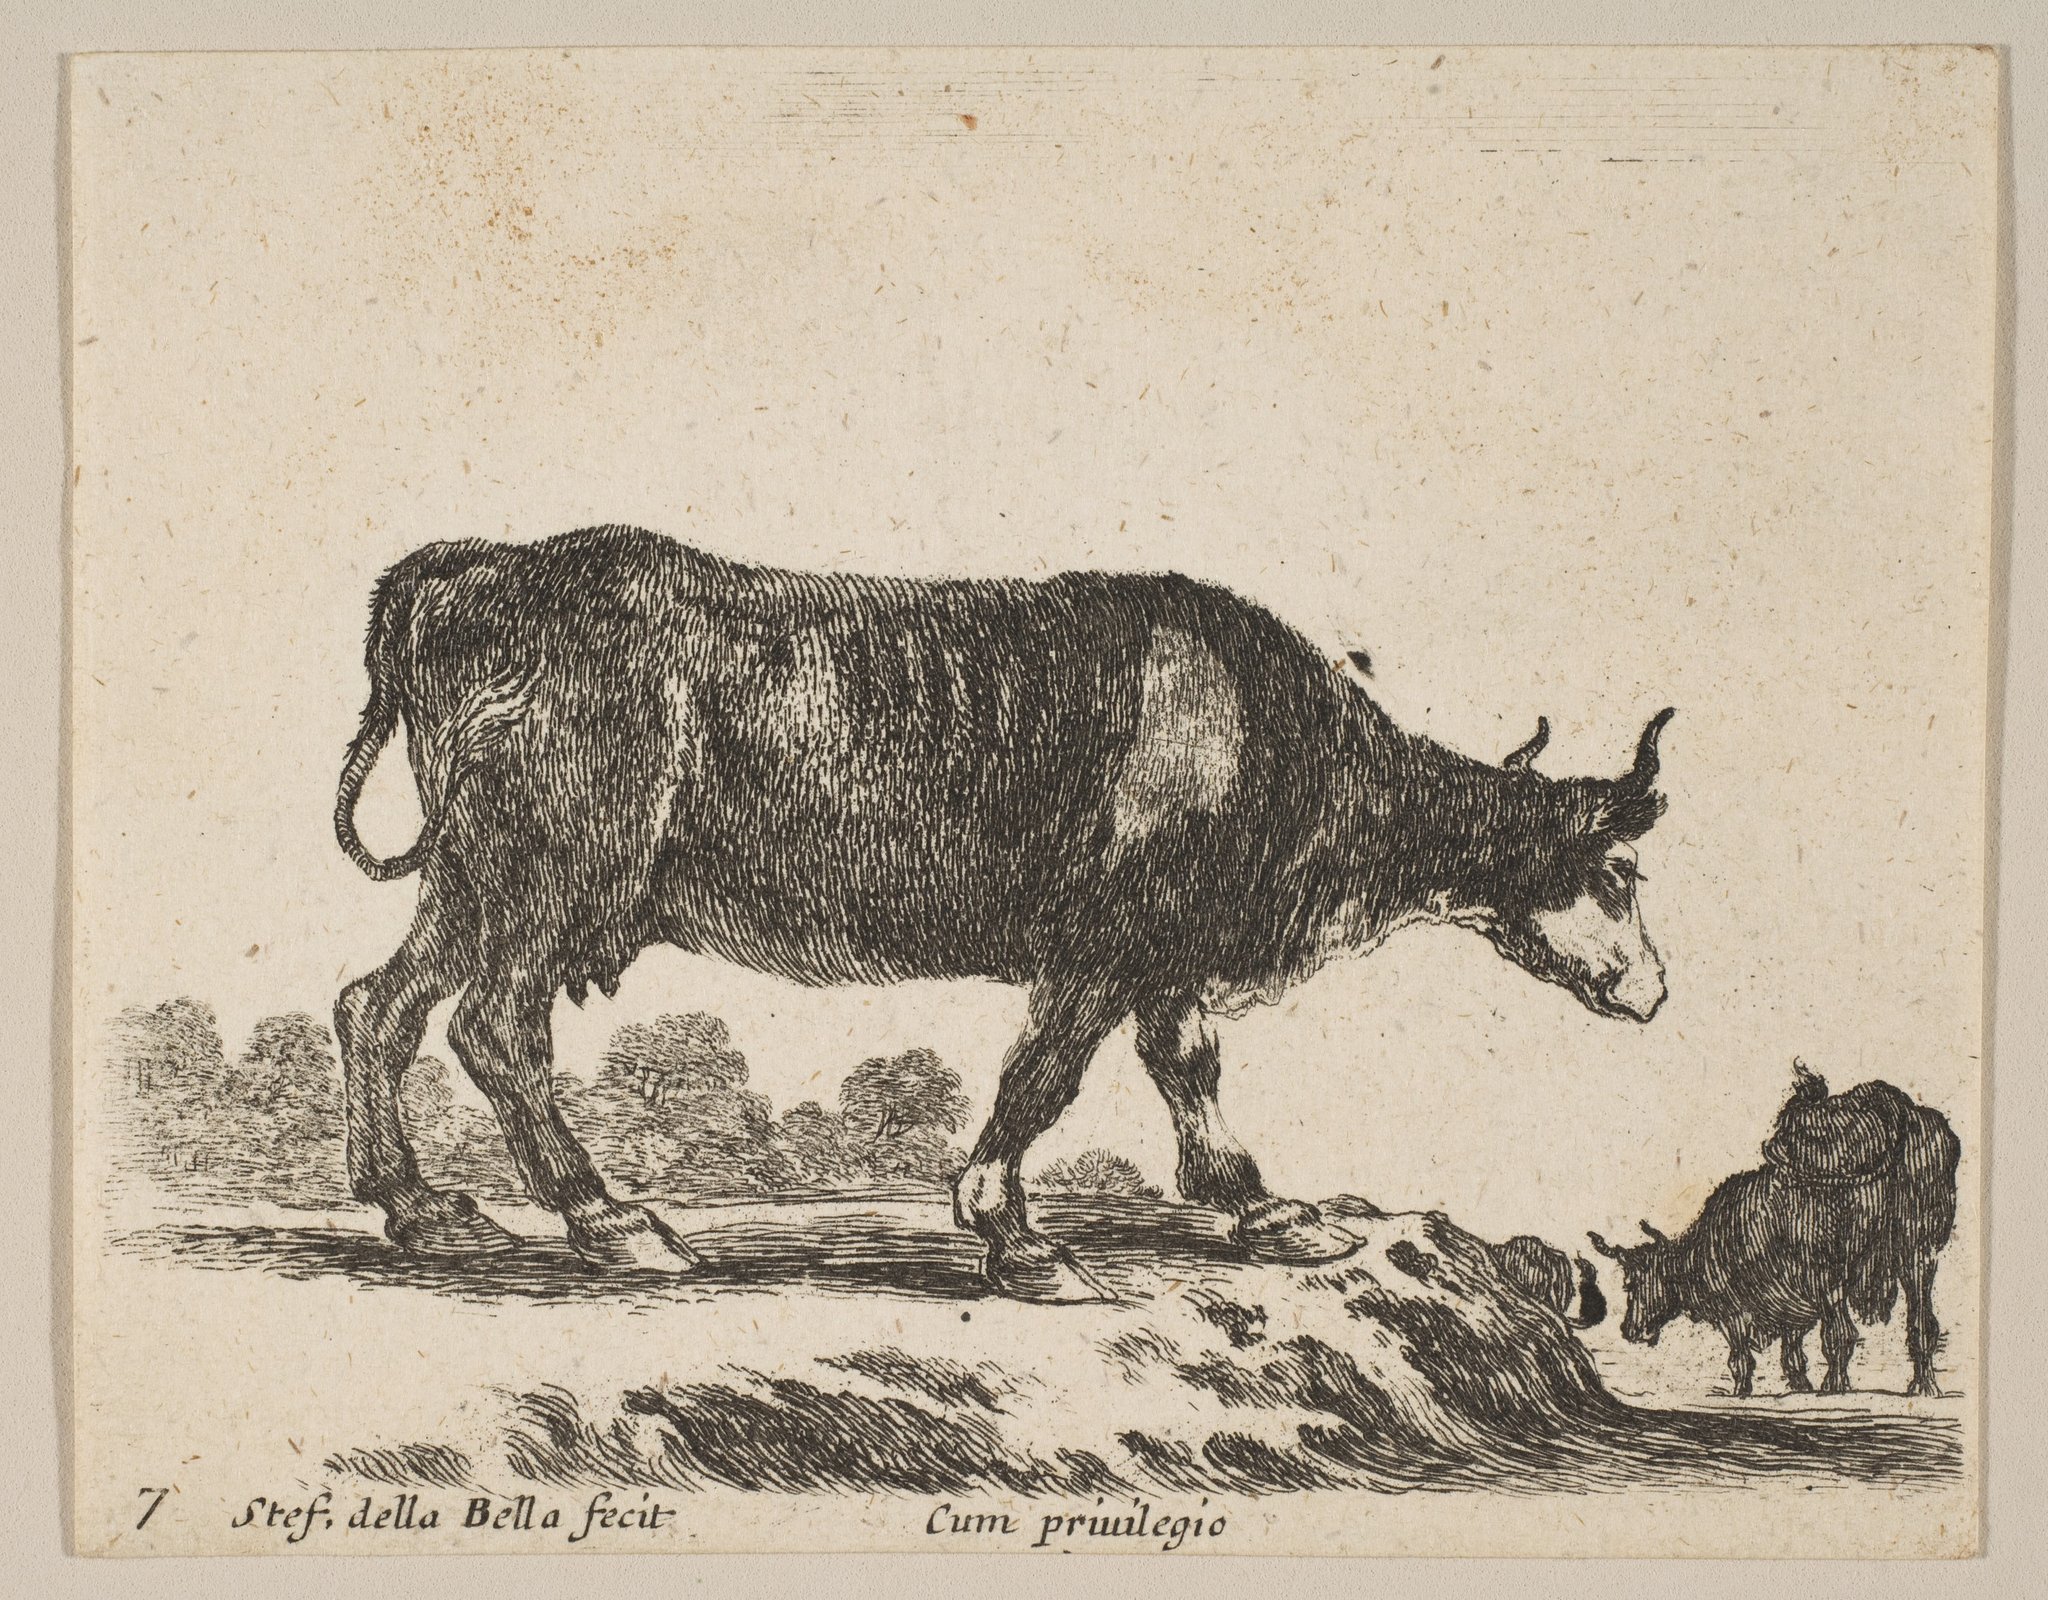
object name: print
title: Plate 7: Cow, from "Various animals" (Diversi animali)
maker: stefano della bella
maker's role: artist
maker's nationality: italian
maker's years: 1610-1664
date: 1641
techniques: etching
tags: cows